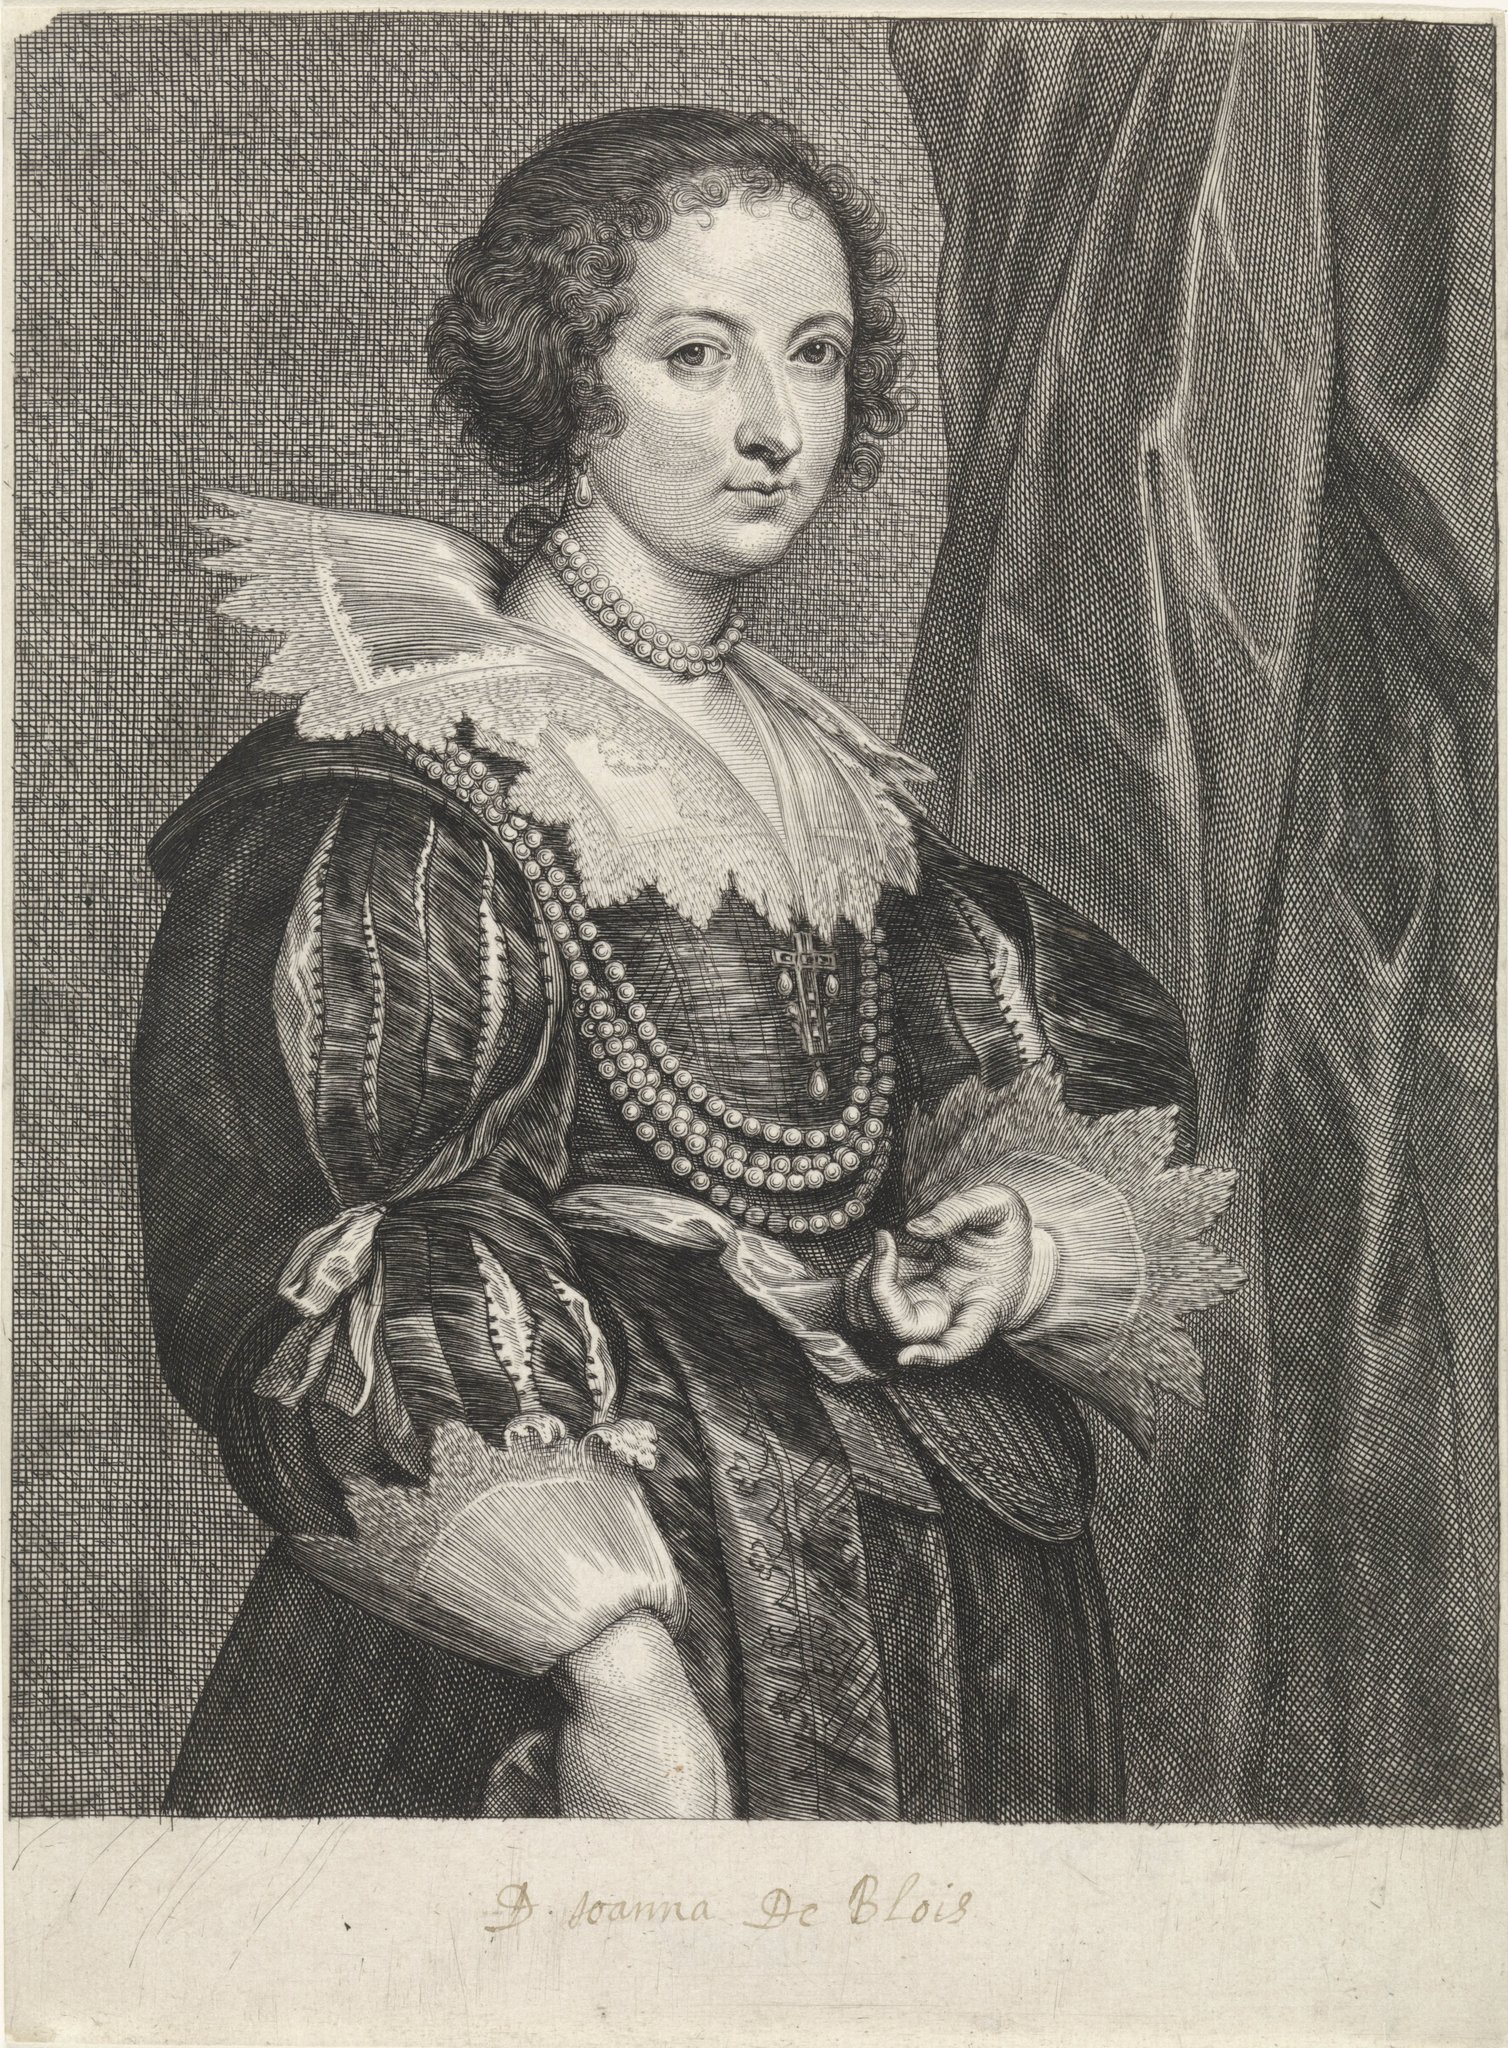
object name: print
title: Portret van Johanna van Blois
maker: pieter de jode (ii)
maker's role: draughtsman, print maker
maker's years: 1606-1674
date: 1628-1670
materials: paper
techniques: engraving, etching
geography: antwerp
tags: johanna van blois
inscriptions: inscription: ‘D. Joanna De Blois’, collector's mark: Lugt 240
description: Portret van Johanna van Blois, ten halven lijve. In de lege marge de naam van de geportretteerde handgeschreven met bruine inkt.